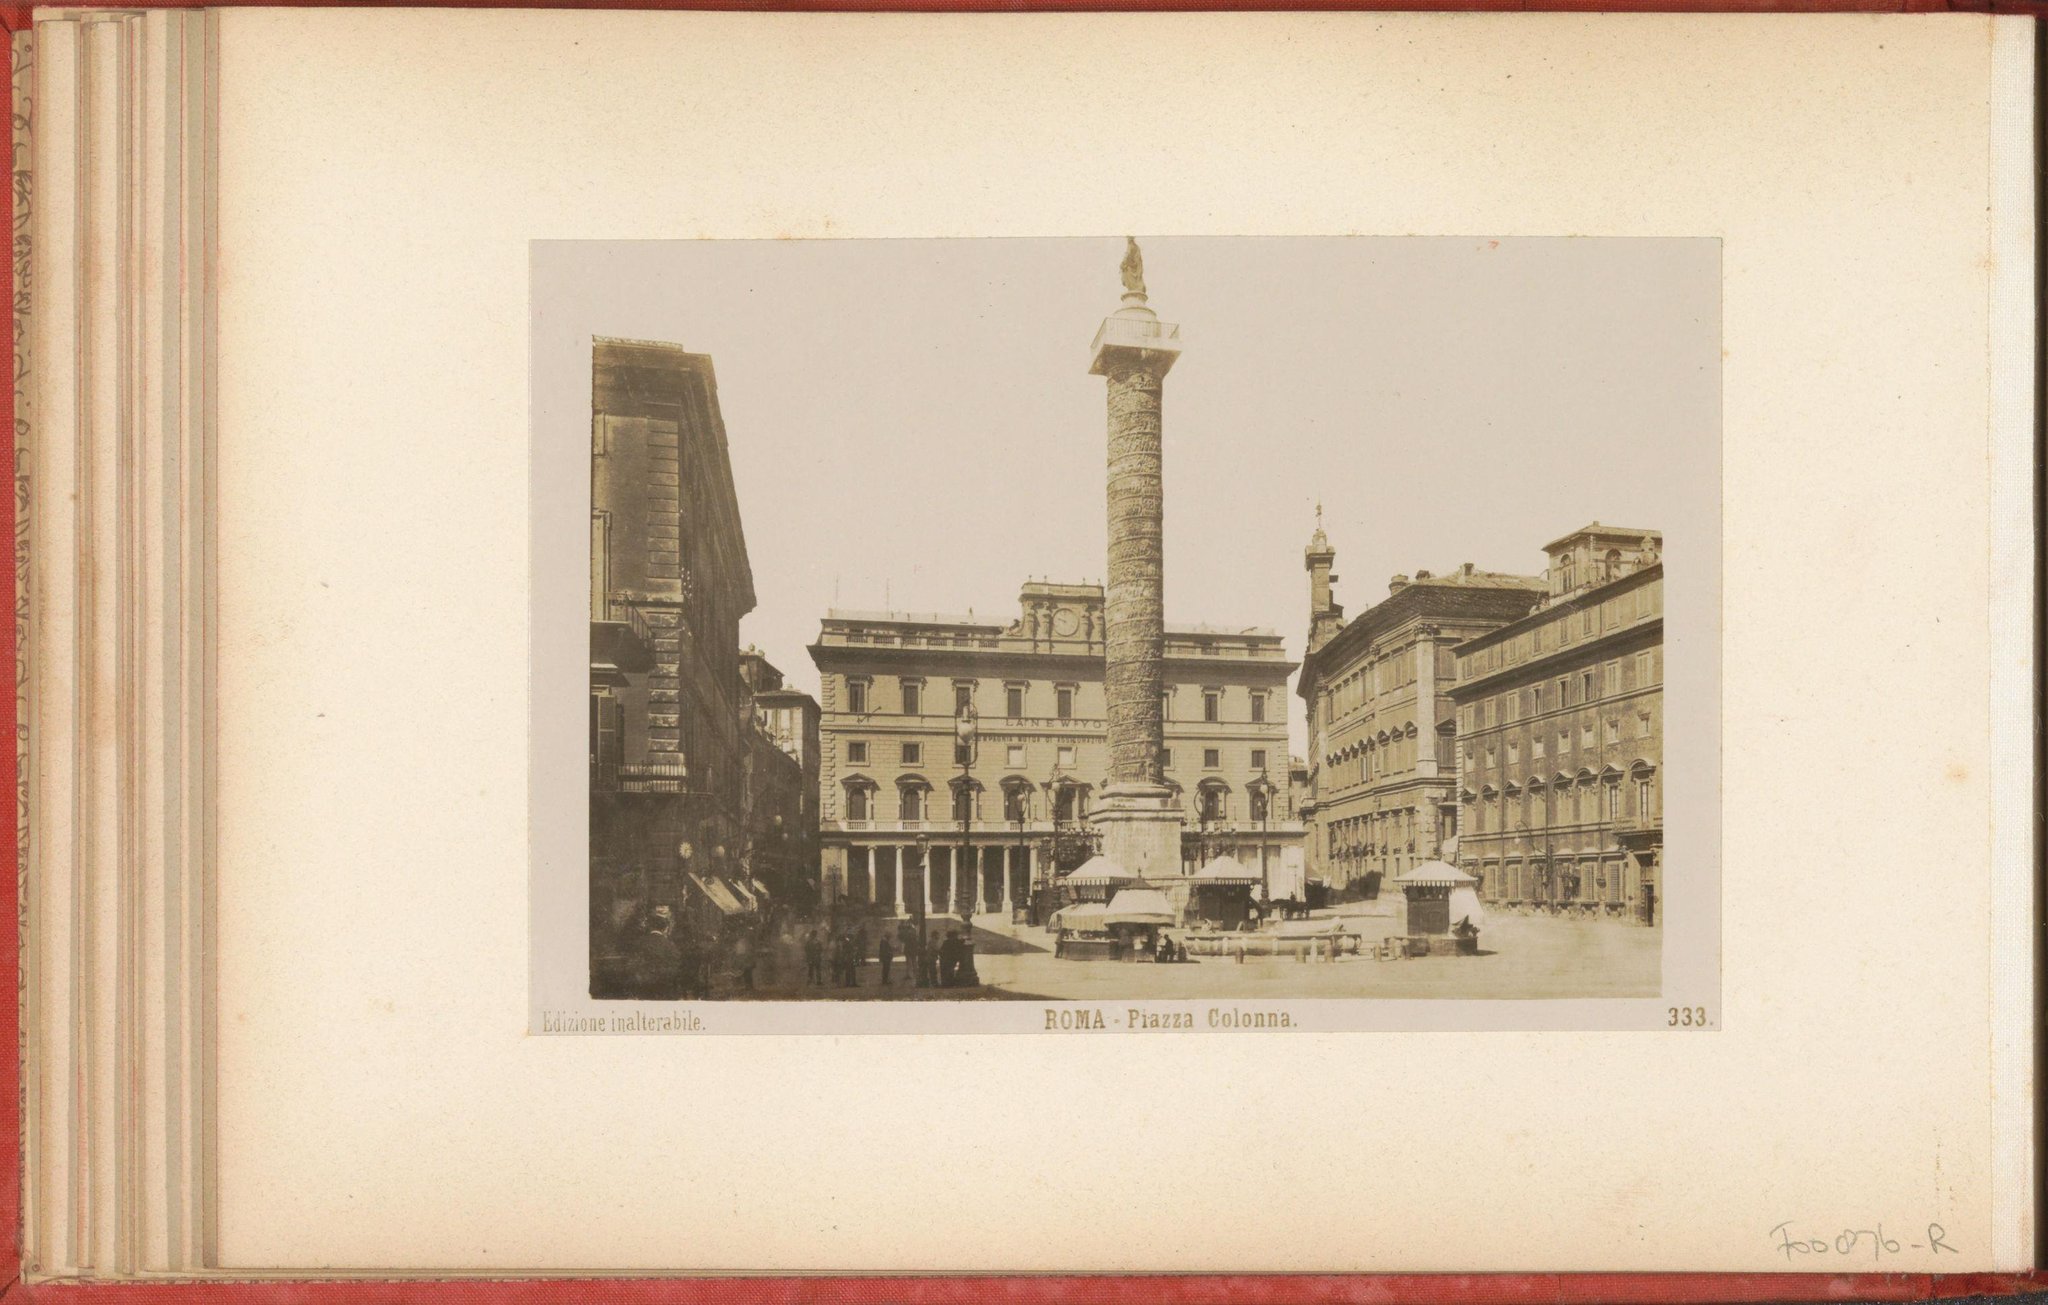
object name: photograph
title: Piazza Colonna met de zuil van Marcus Aurelius in Rome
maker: Anonymous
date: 1860-1890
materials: cardboard, photographic support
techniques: gelatin silver print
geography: rome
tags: triumphal column with helical friezes (+ variant), square, place, circus, etc. (+ city(-scape) with figures, staffage), prospect of city, town panorama, silhouette of city, rome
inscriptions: number: ‘333’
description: Onderdeel van Fotoalbum met opnames van kerken, beelden en antieke gebouwen in Rome.